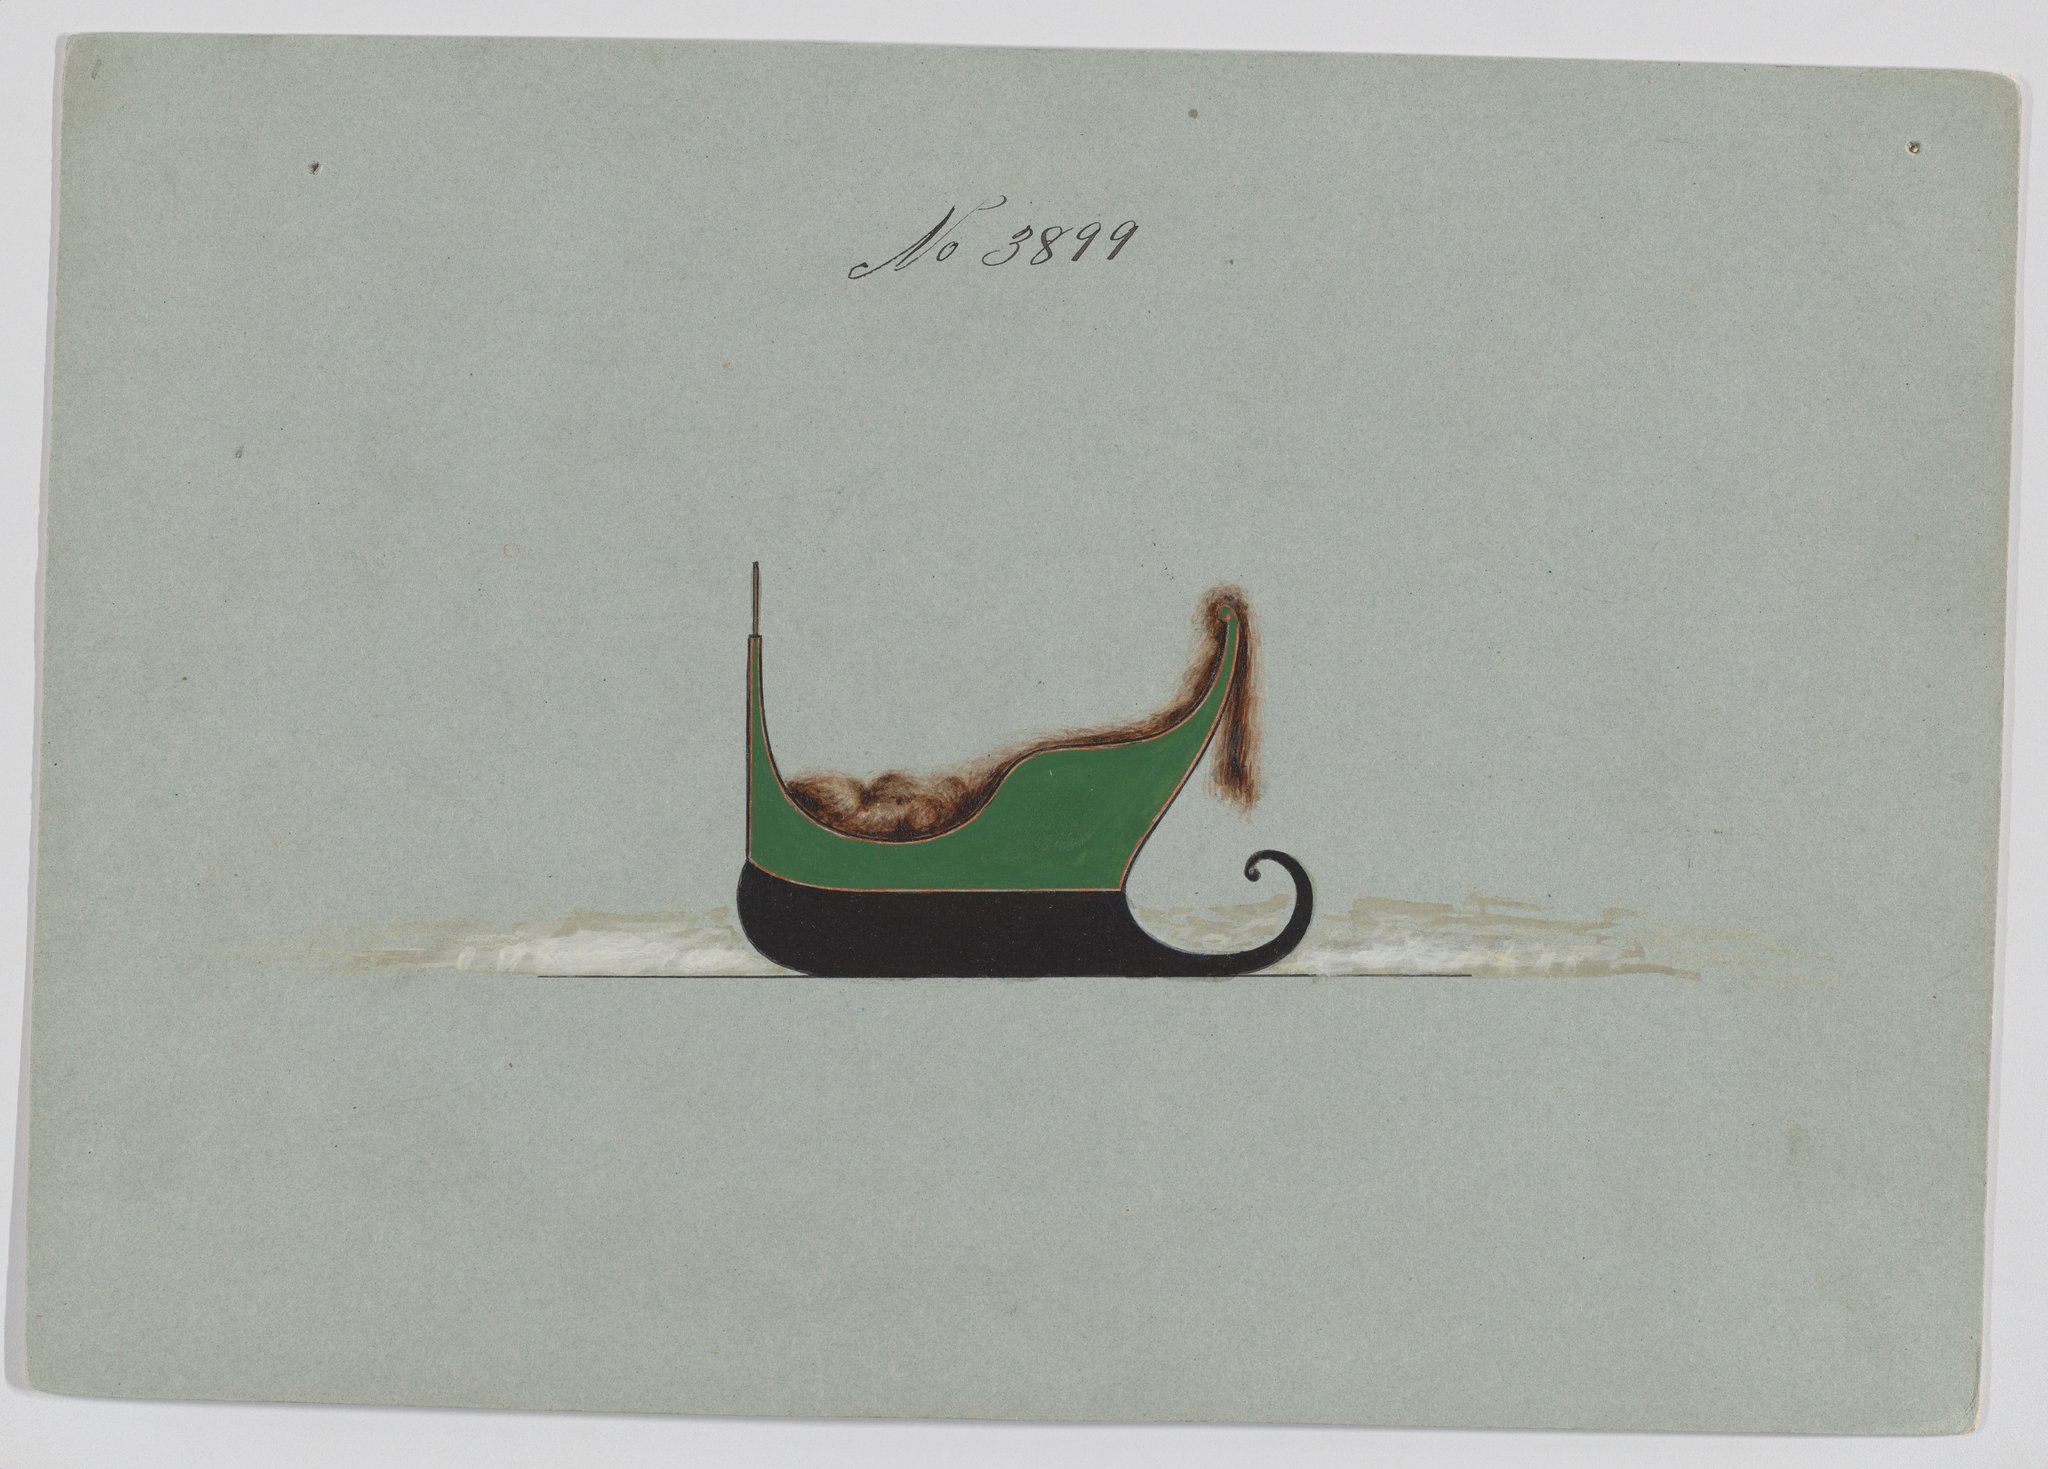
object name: drawing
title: Design for Cutter, no. 3899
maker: brewster & co.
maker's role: manufacturer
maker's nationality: american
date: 1884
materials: gouache, gum arabic, ink, watercolor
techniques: pen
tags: sleighs